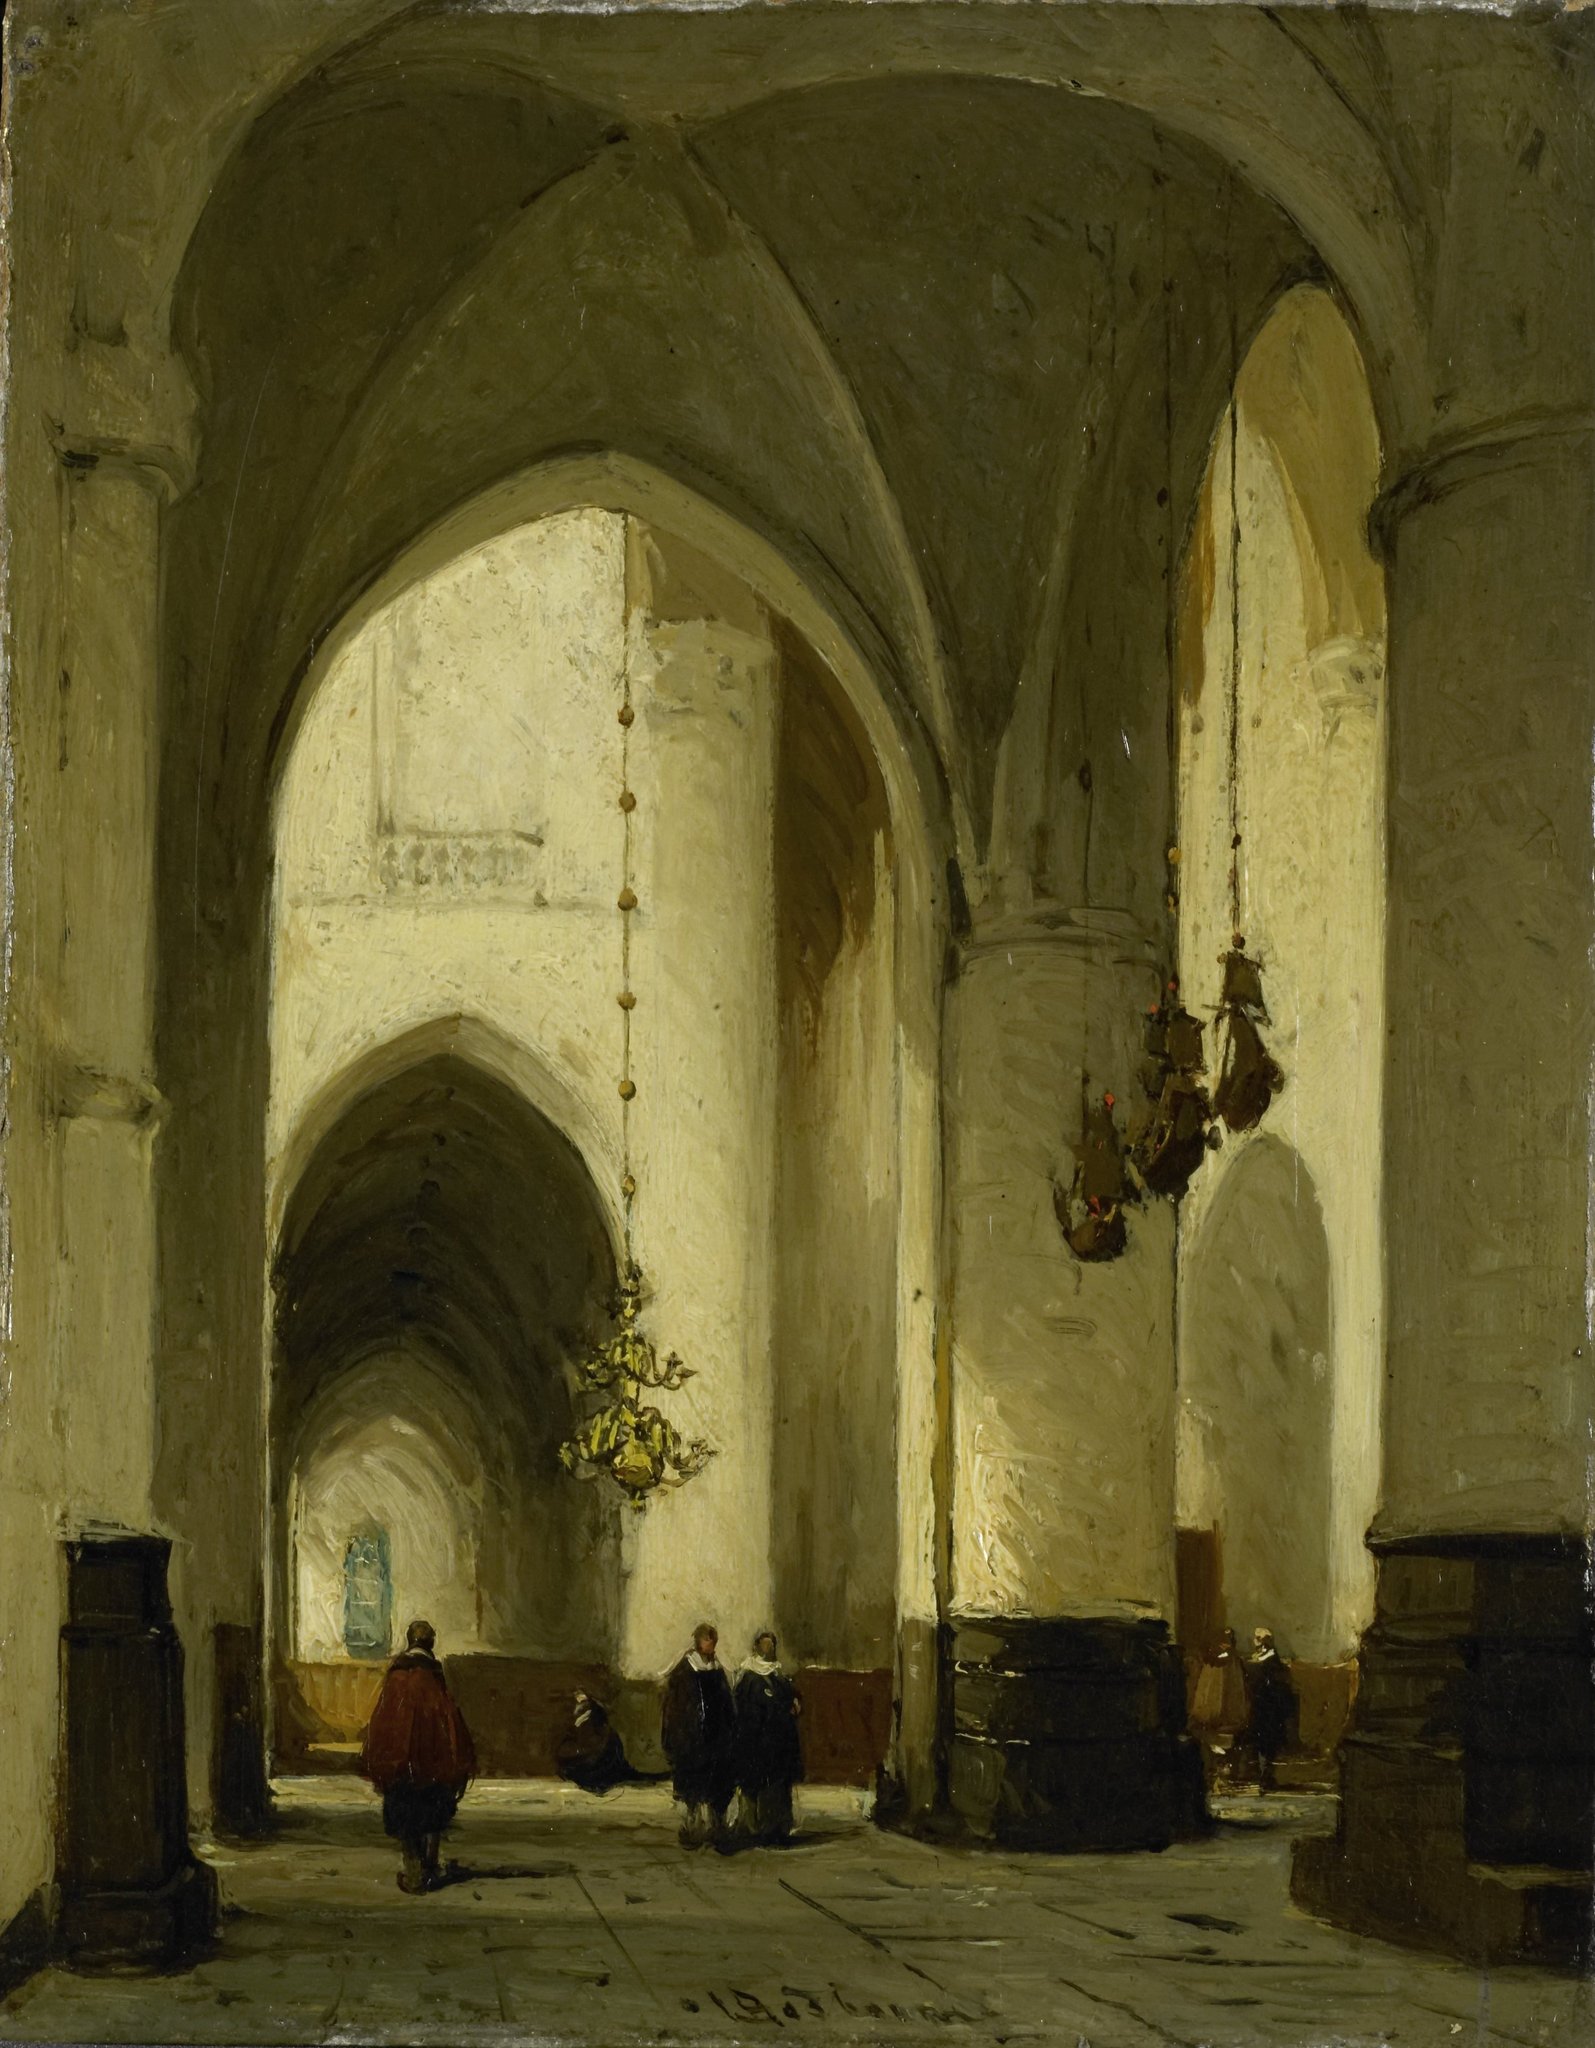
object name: painting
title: Interior of the Church of St Bavo in Haarlem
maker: johannes bosboom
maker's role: draughtsman, painter, print maker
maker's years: 1817-1891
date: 1860-1891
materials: oil, panel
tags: interior of church, haarlem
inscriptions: signature: ‘J. Bosboom’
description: Interieur van de Grote of Sint-Bavokerk te Haarlem. Van het plafond hangen drie scheepsmodellen.